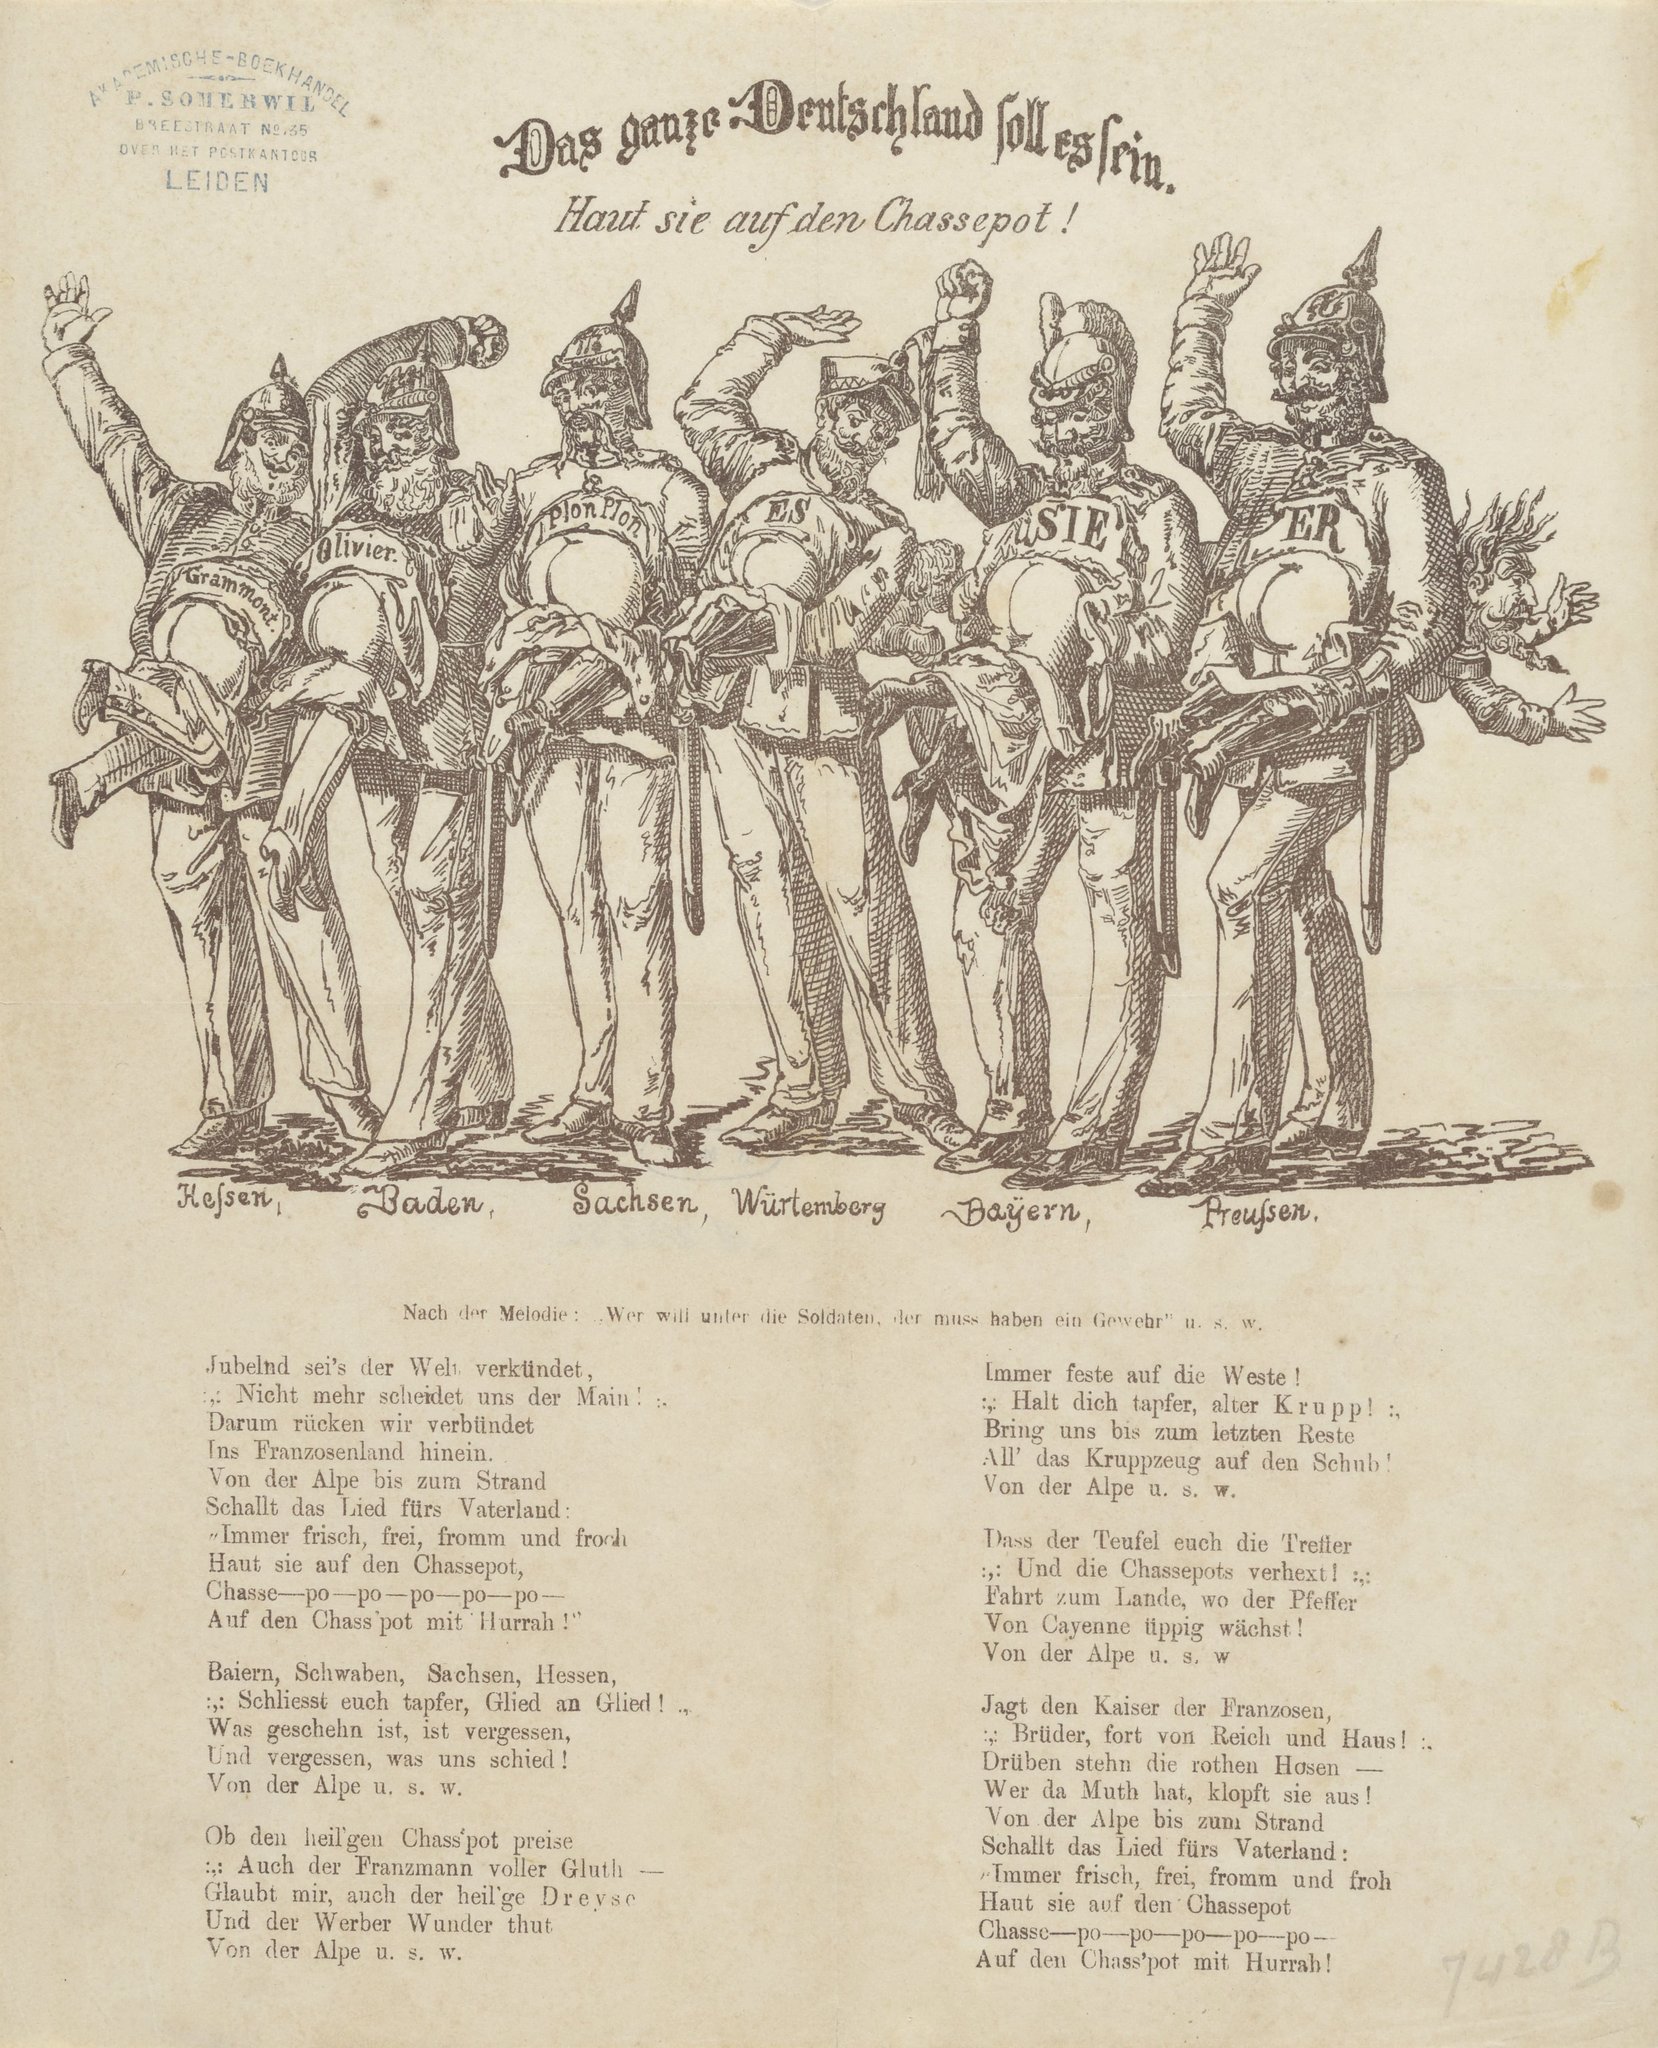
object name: print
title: Das ganze Deutschland soll es sein. Haut sie auf den Chassepot!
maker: Anonymous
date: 1870-1871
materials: paper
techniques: lithograph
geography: germany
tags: paris, london, napoleon iii (keizer der fransen), spanking, drubbing (of naughty children)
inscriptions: company name: ‘Akademische-Boekhandel P. Somerwil / Breestraat No. 35 / over het postkantoor / Leiden’, collector's mark: Lugt 2228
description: Spotprent op de nederlagen van Frankrijk in de Frans-Duitse oorlog van 1870-1871. De verschillende Duitse staten slaan de Franse generaals op hun blote achterwerk, uiterst rechts keizer Napoleon III. In het onderschrift een Duits vers in zes coupletten.